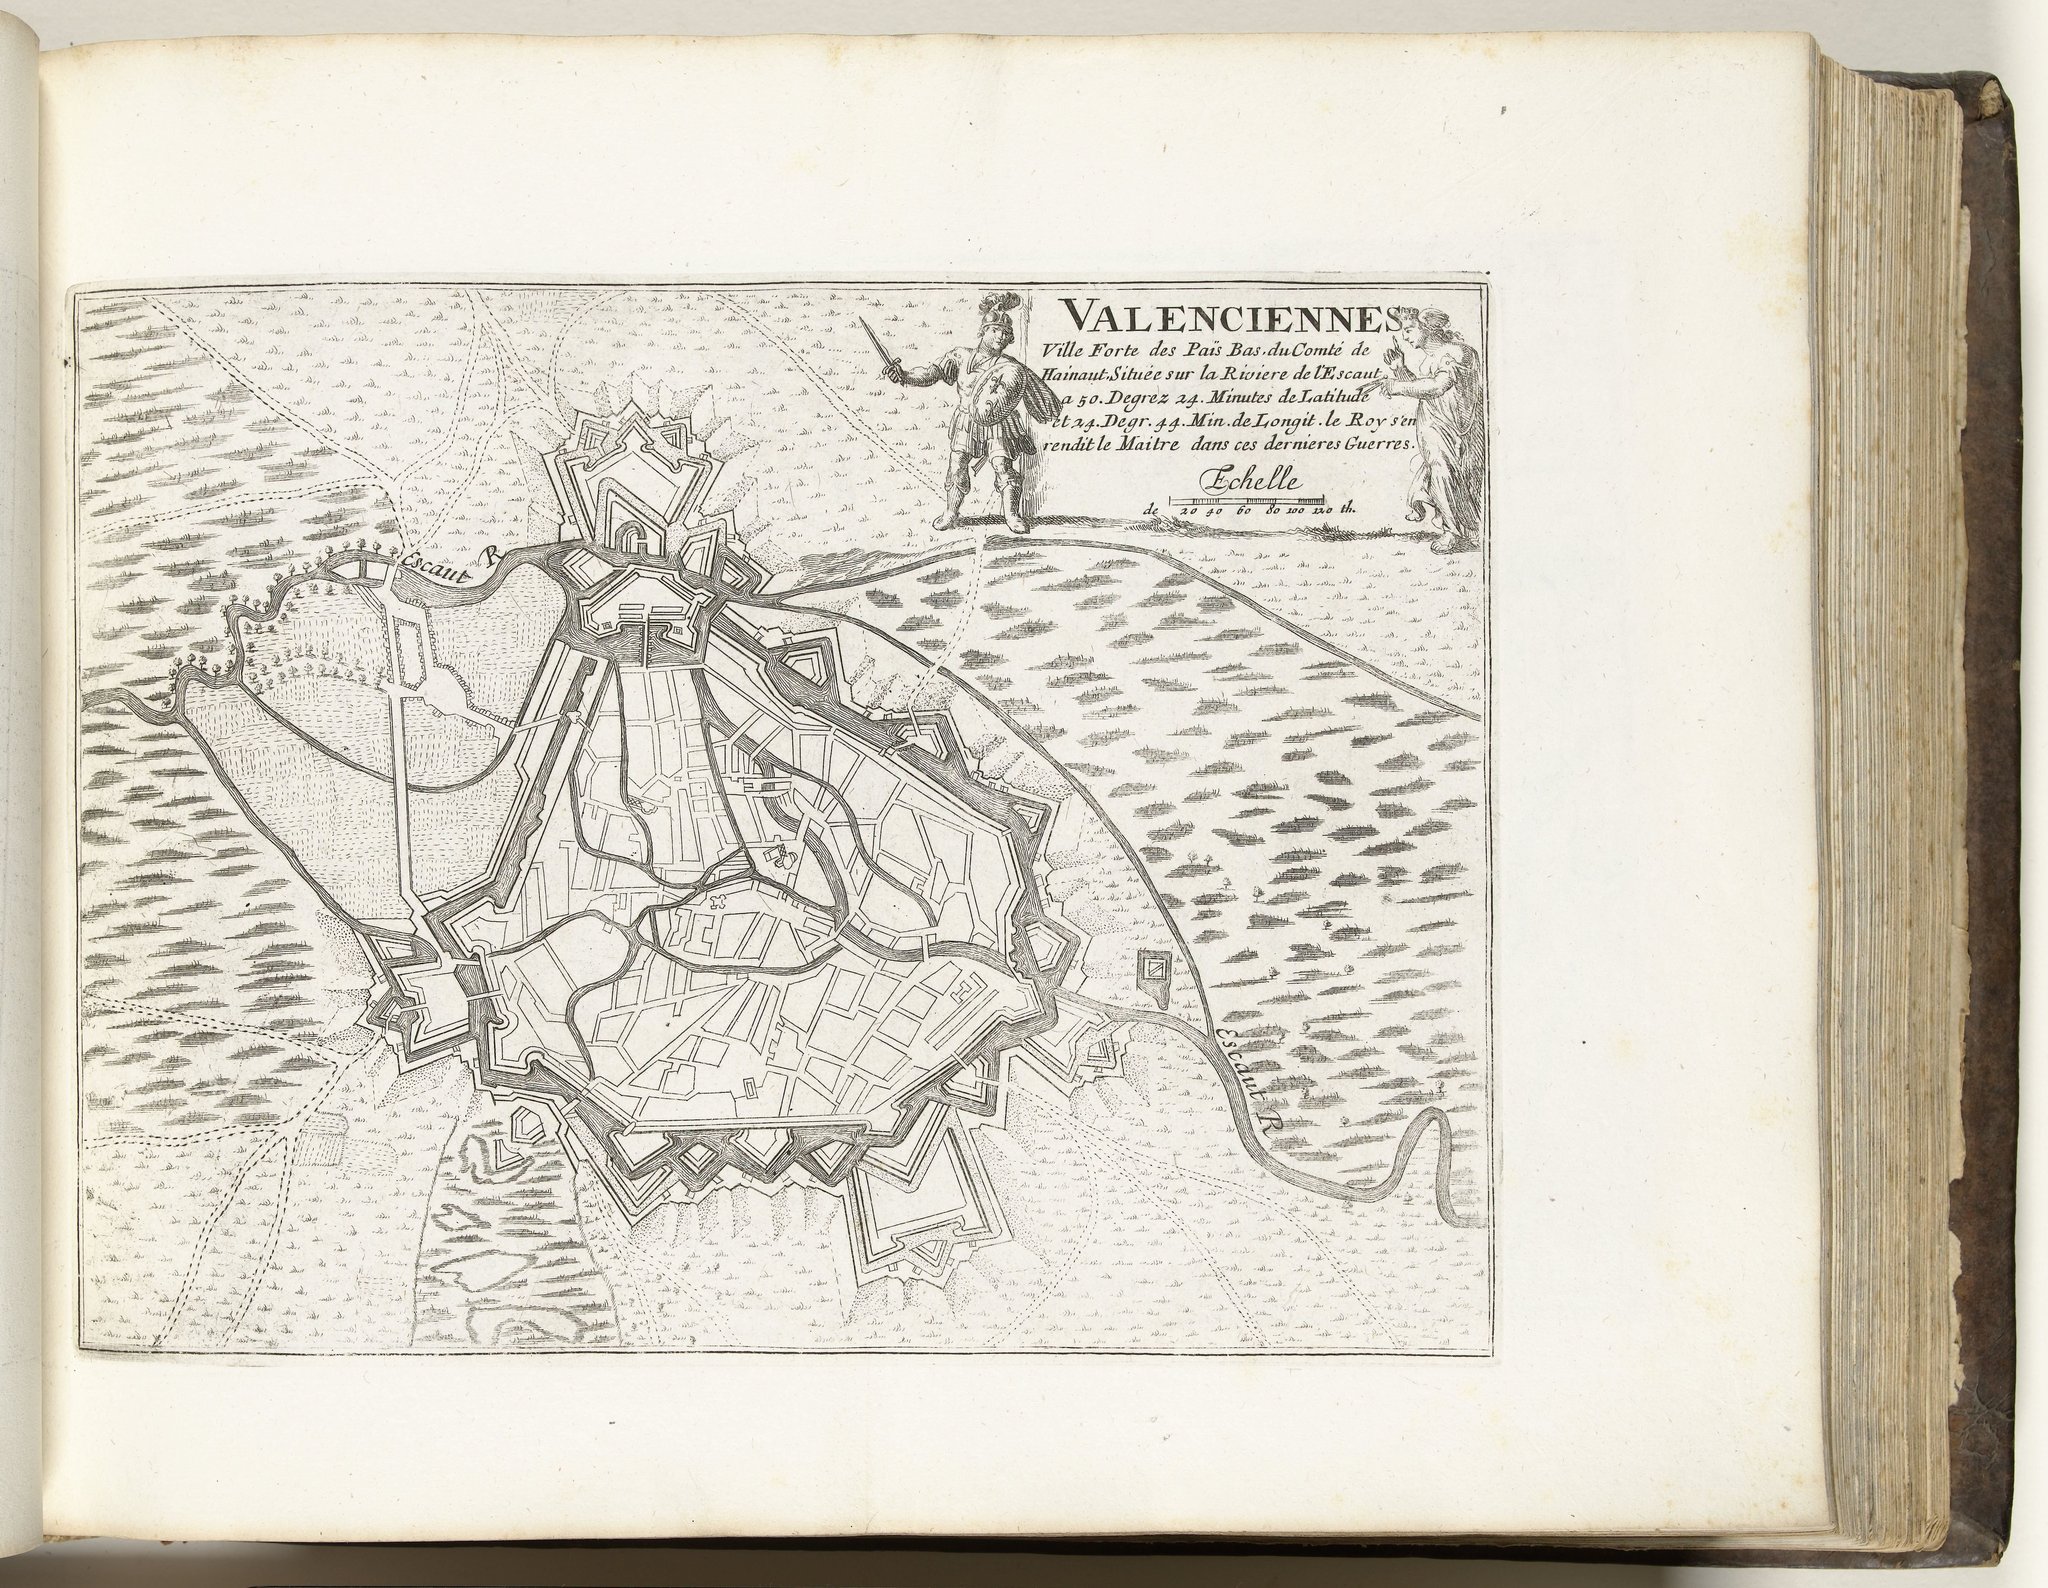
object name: print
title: Valenciennes Ville Forte des Pais Bas, du Comté de Hainault (...)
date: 1695-1697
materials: paper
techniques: etching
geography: paris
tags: fortress, maps of cities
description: Plattegrond van de versterkingen om de Vlaamse stad Valenciennes. Onderdeel van het vierde deel (1697) van het prentwerk waarin gebundeld zijn de acht delen van Les forces de l'Europe uitgegeven tussen 1693-1697. Het prentwerk bestaat uit 175 platen met plannen (afkomstig van Sébastien Le Prestre, Seigneur de Vauban) van vermaarde sterke steden en vestingen in de Negenjarige Oorlog. Titel en opschriften in het Frans.